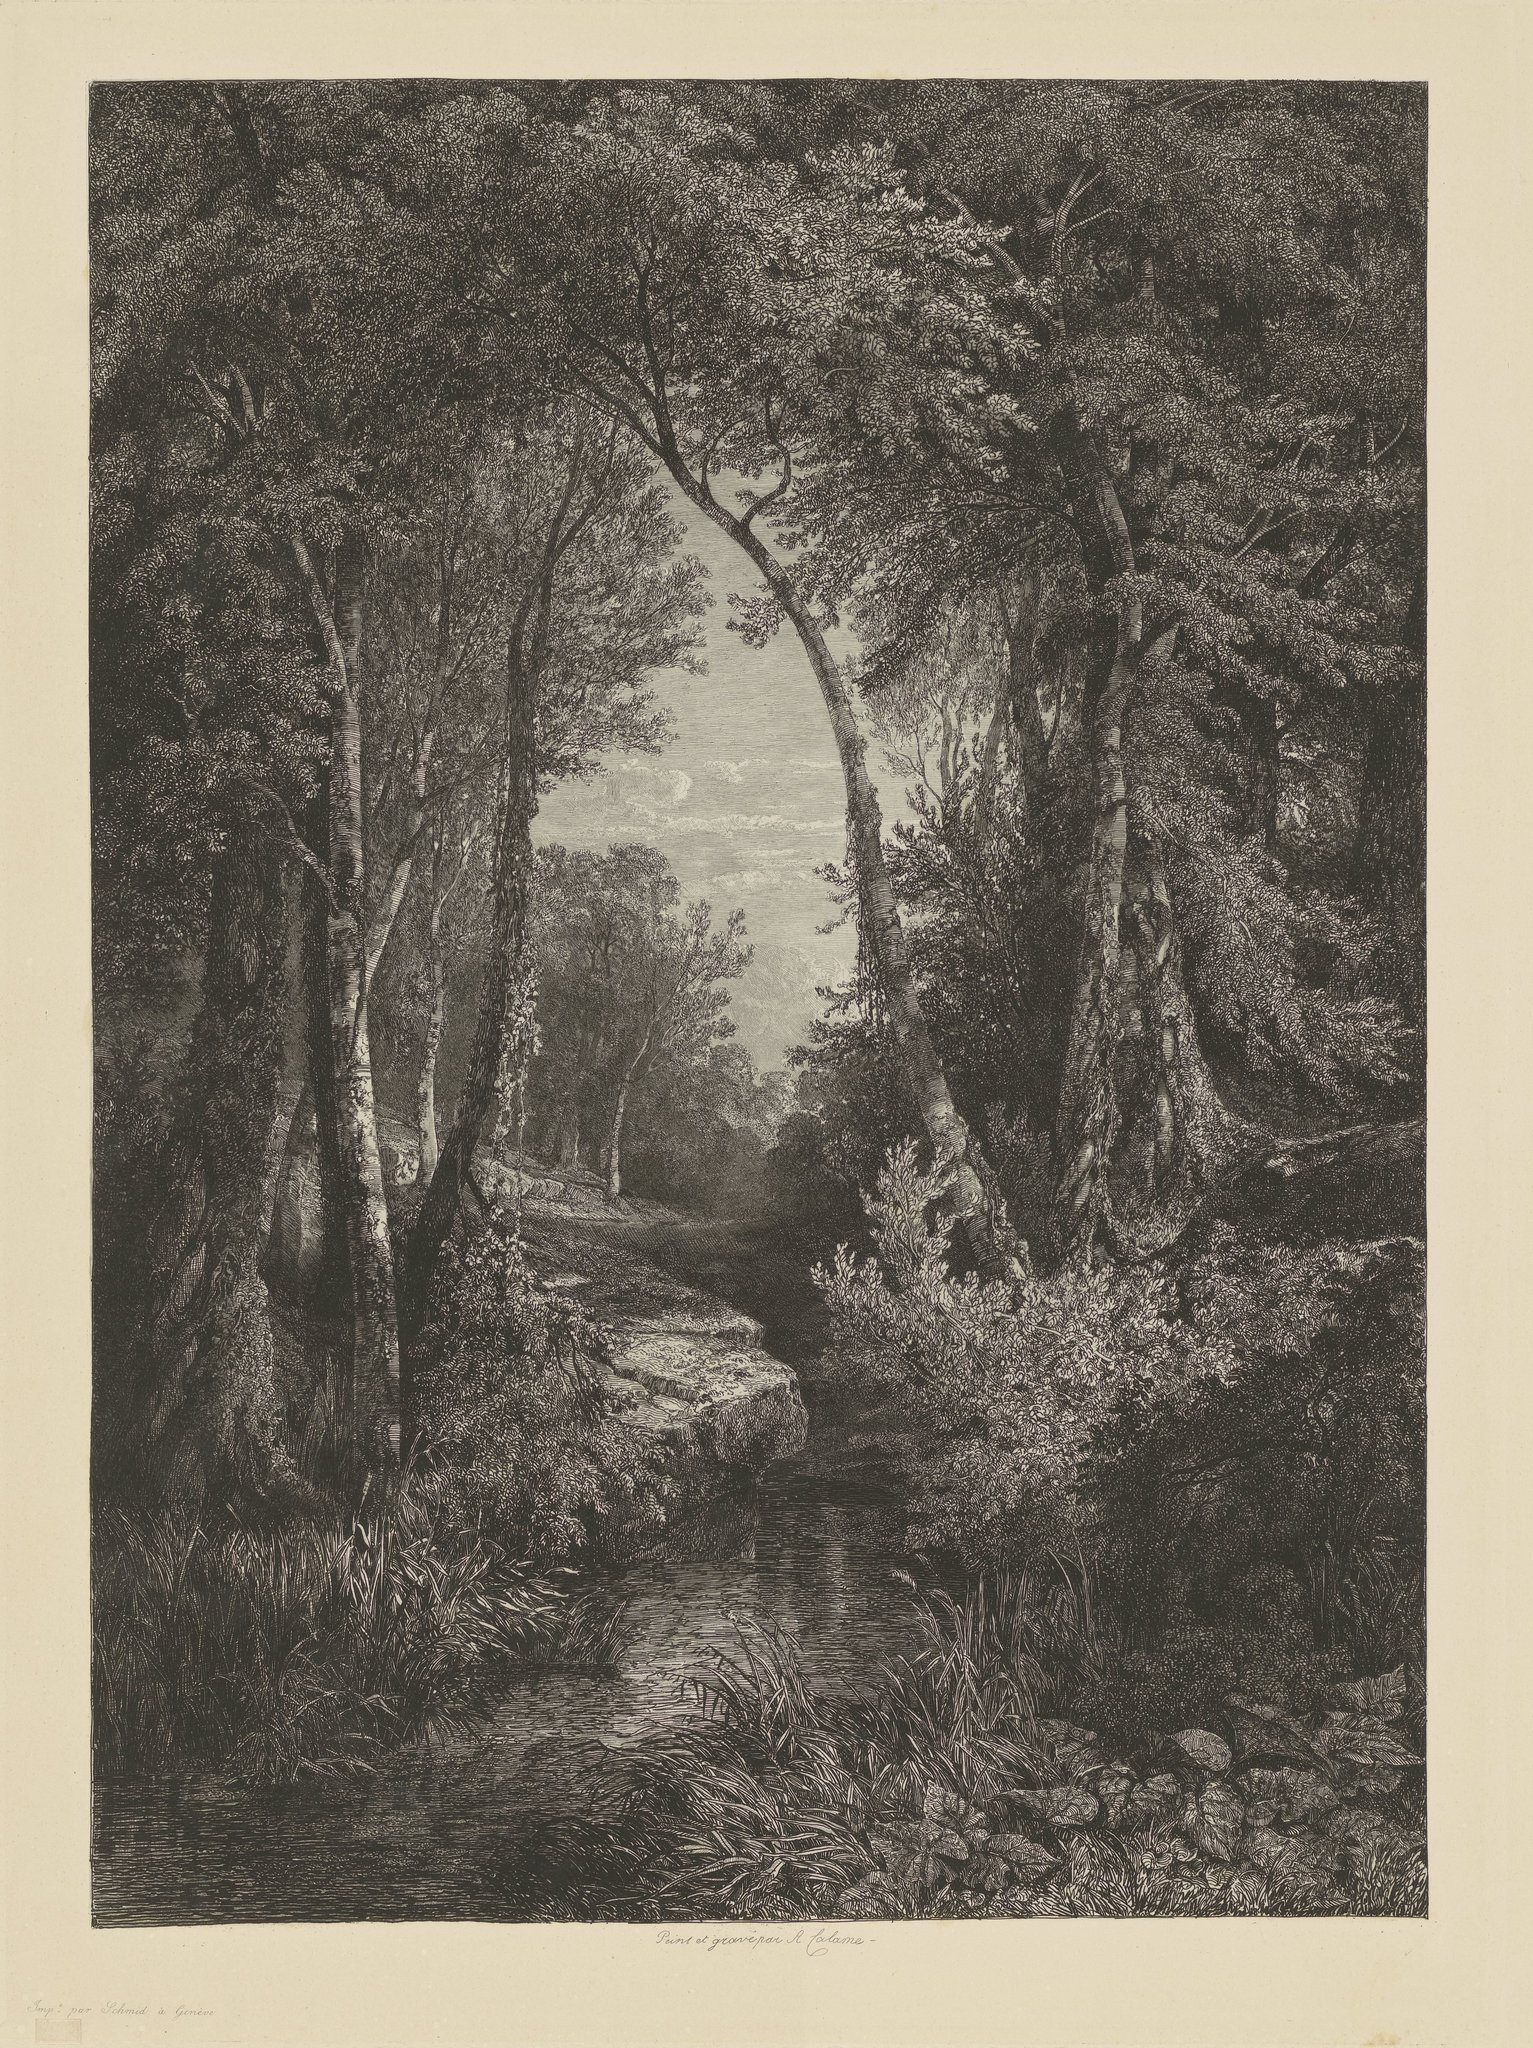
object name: print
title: Boslandschap met beek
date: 1850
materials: paper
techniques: engraving, etching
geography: geneva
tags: forest, wood, brook, switzerland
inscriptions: collector's mark: Lugt 12